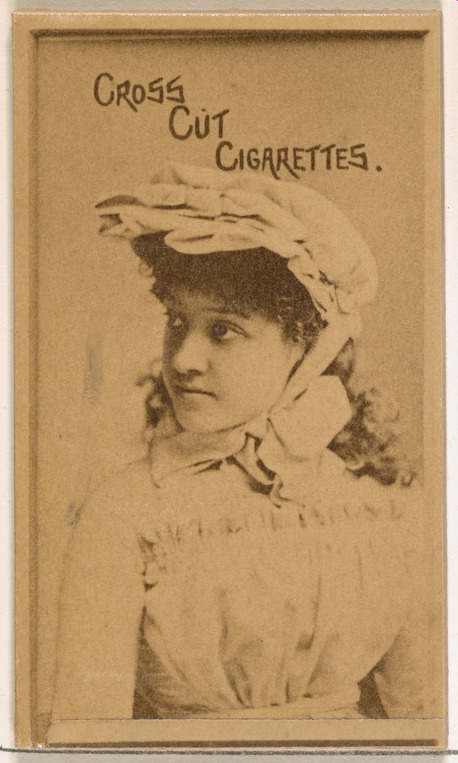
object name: print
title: Actress wearing white cloth bonnet, from the Actors and Actresses series (N145-1) issued by Duke Sons & Co. to promote Cross Cut Cigarettes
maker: w. duke, sons & co.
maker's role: publisher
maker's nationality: american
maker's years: 1870-1920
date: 1880-1889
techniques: albumen silver print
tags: portraits,women,actresses